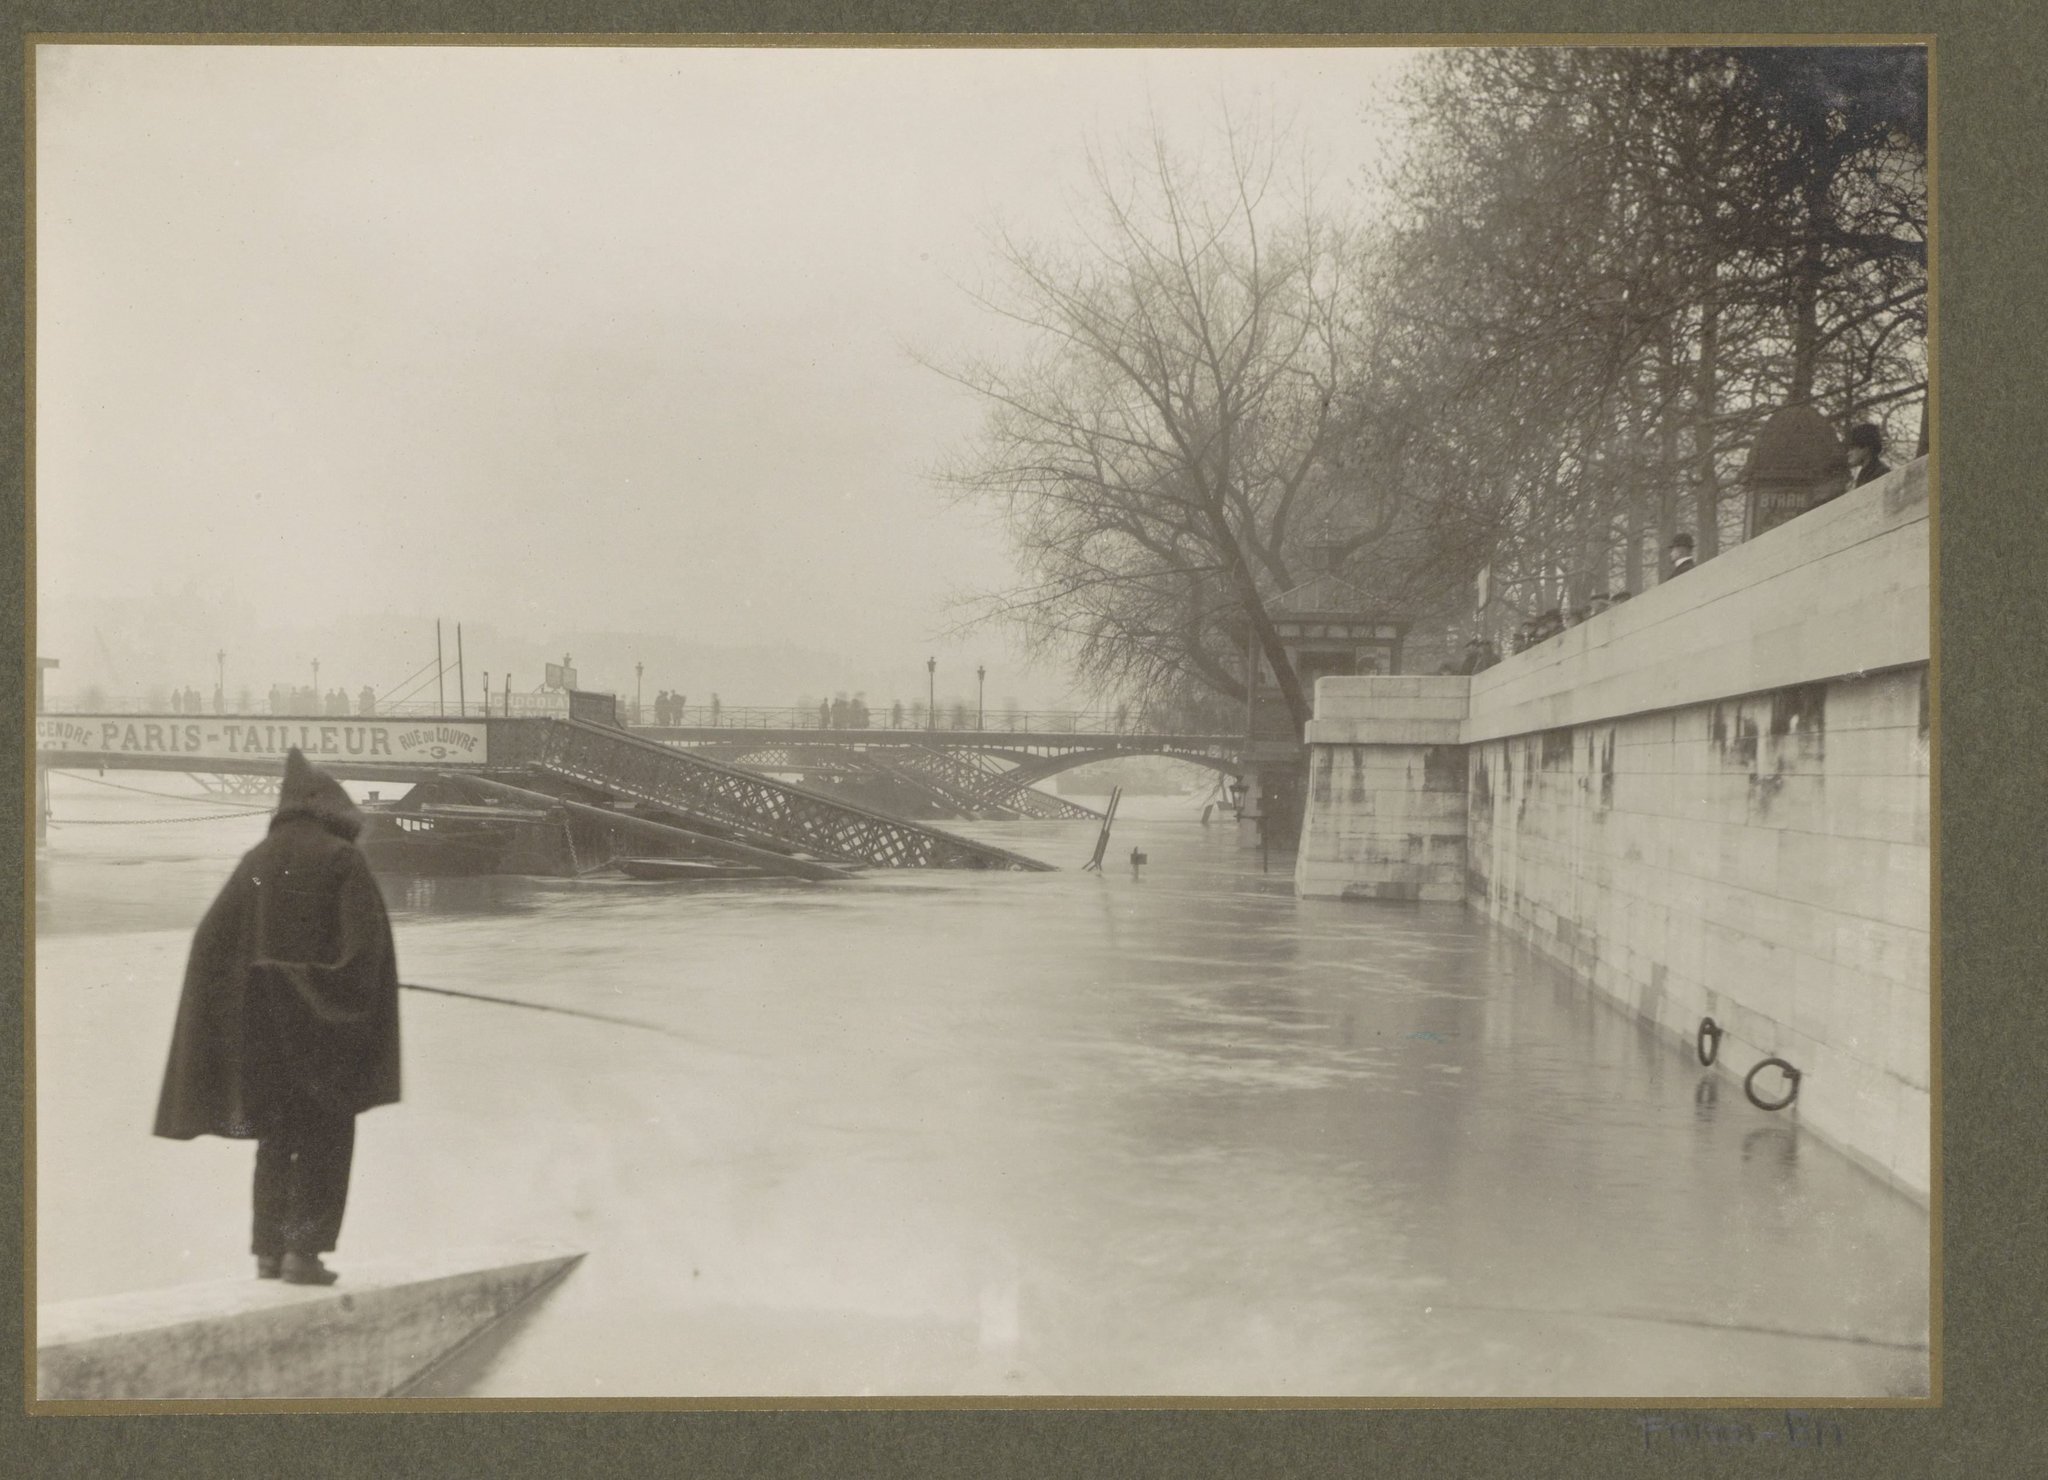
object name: photograph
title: Ondergelopen Seine-oevers, verwoeste bruggen en een hengelaar tijdens overstroming van Parijs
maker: g. dangereux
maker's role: fotograaf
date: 1901-1910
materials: photographic support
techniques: matte daylight collodion silver print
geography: paris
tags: flood (+ landscape with figures, staffage), landscape with bridge, viaduct or aqueduct, fisherman, paris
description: Onderdeel van fotoalbum overstroming Parijs en voorsteden 1910.